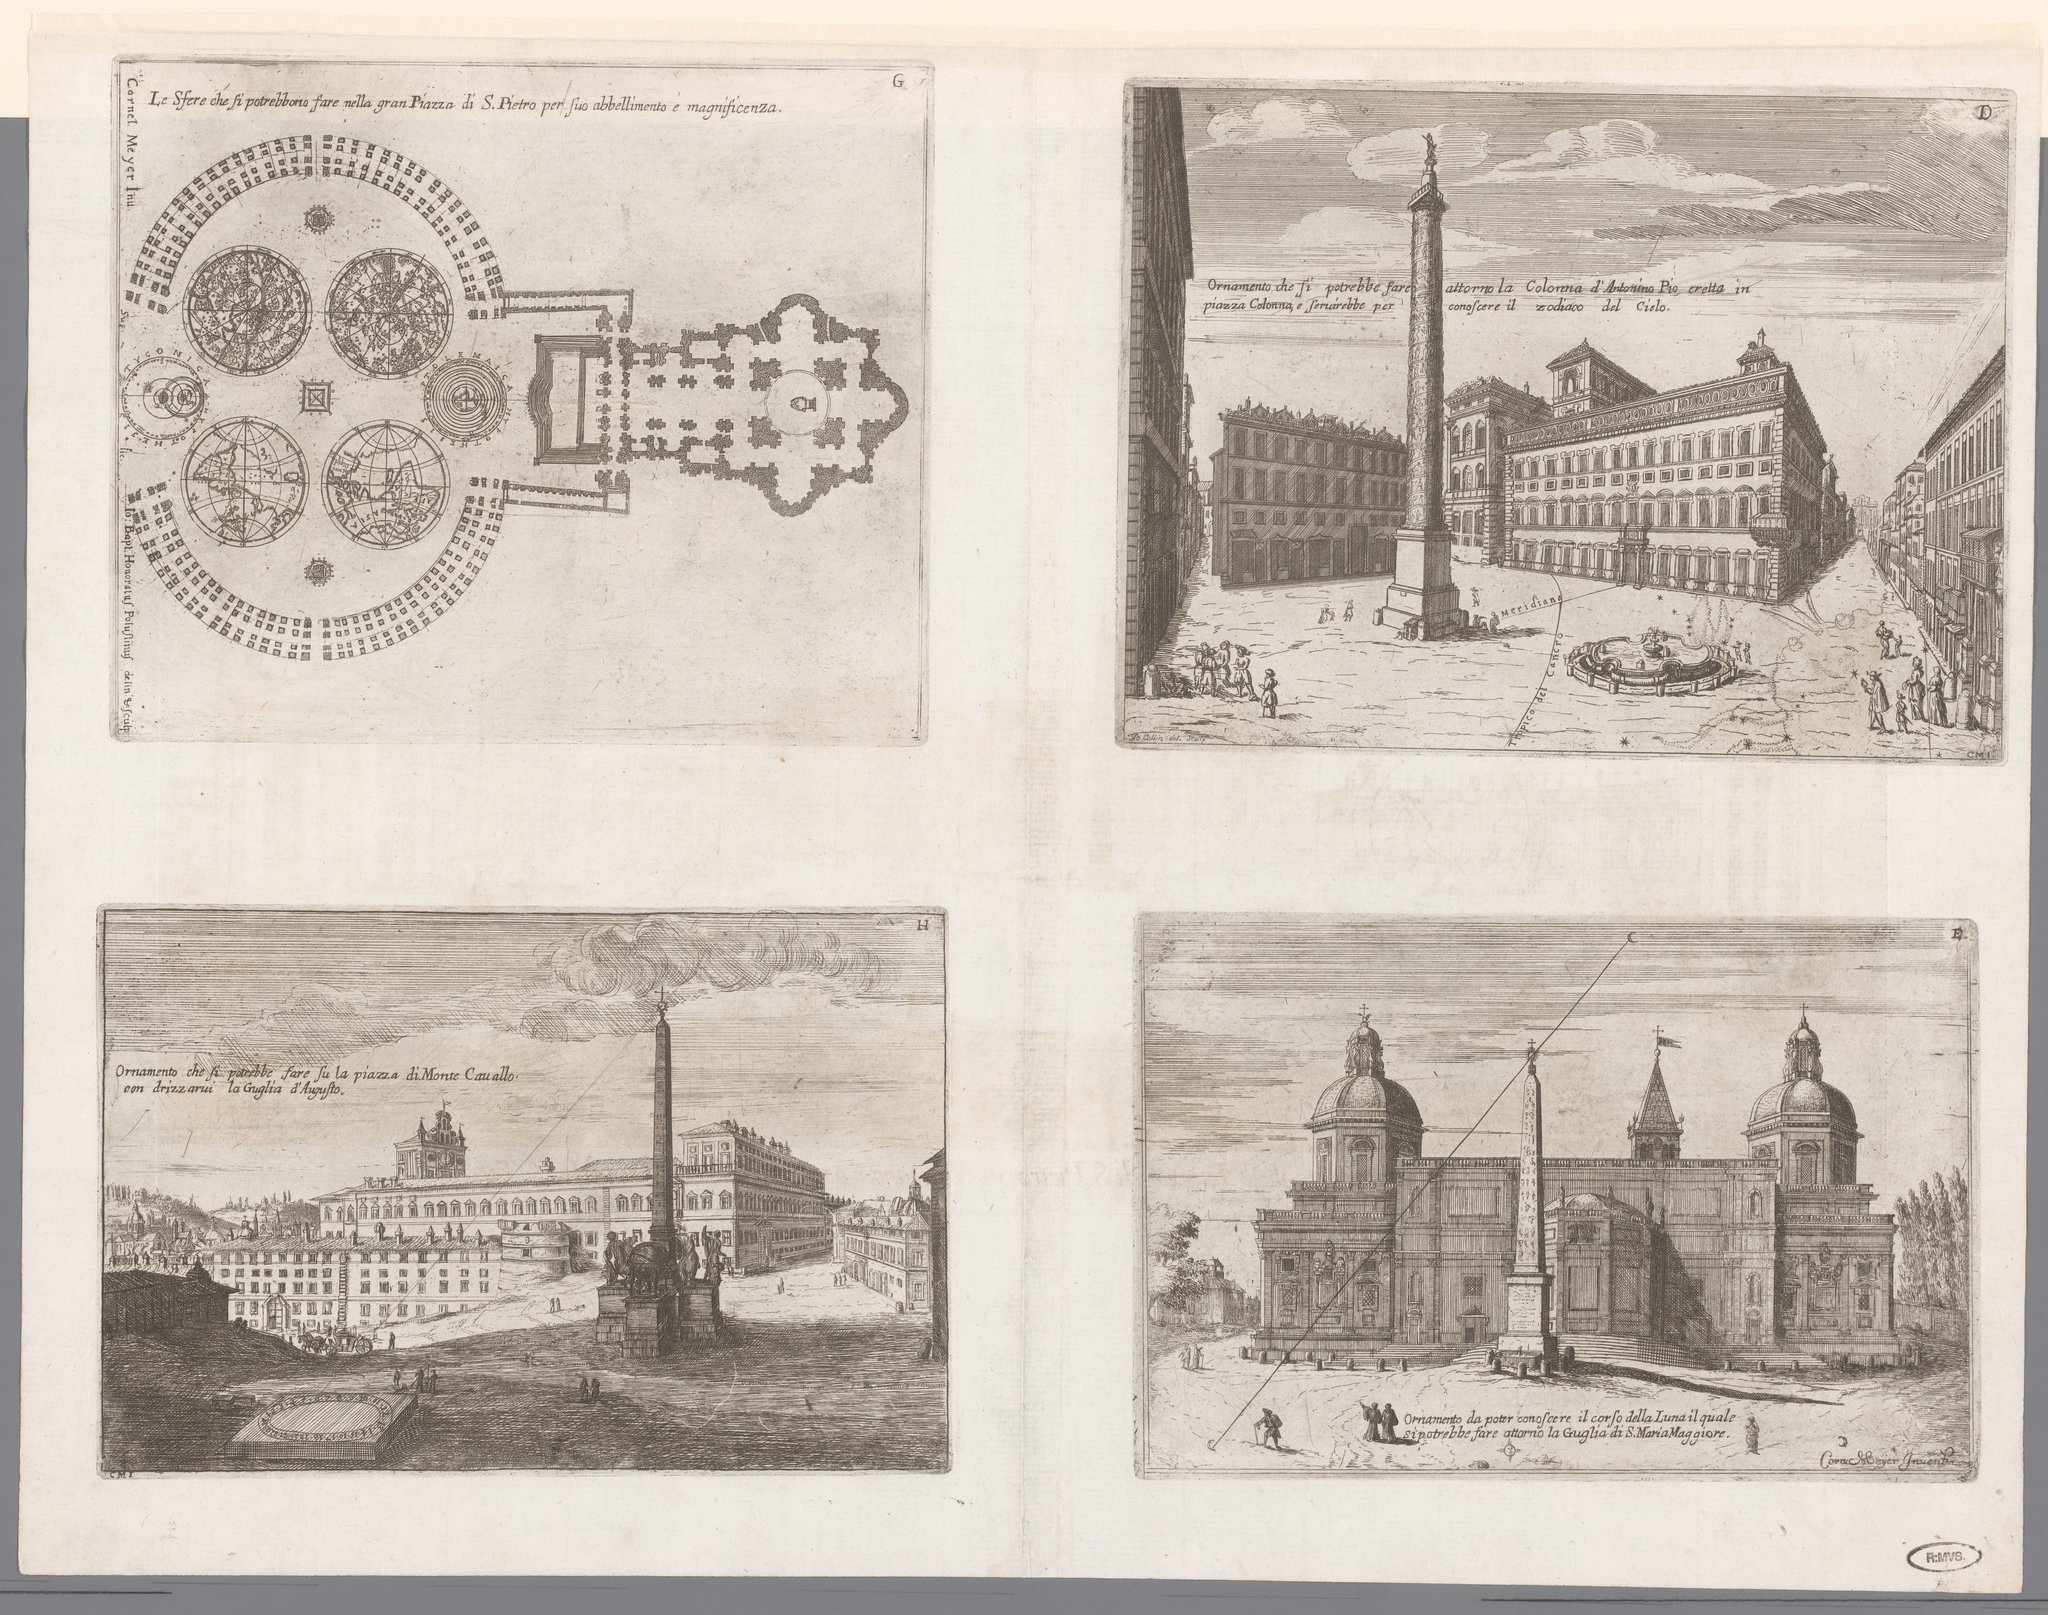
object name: print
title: Plattegrond van het Sint-Pietersplein, gezicht op de Zuil van Antoninus Pius en twee gezichten op obelisken, te Rome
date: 1639-1701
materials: paper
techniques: engraving, etching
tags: square, place, circus, etc., obelisk, needle, church (exterior), triumphal column with helical friezes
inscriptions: collector's mark: Lugt 2228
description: Prenten rechtsboven gemerkt, vanaf linksboven met de klok mee: G, D, E, H.